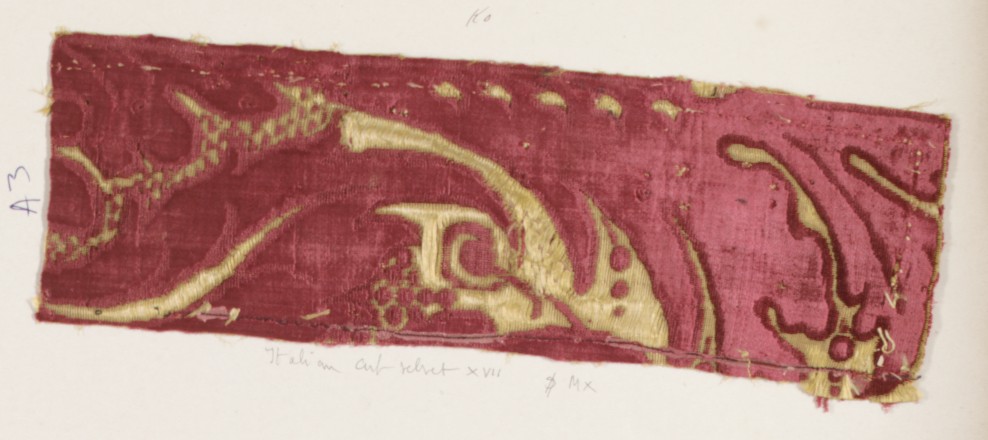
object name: fragment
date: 1601-1700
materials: silk